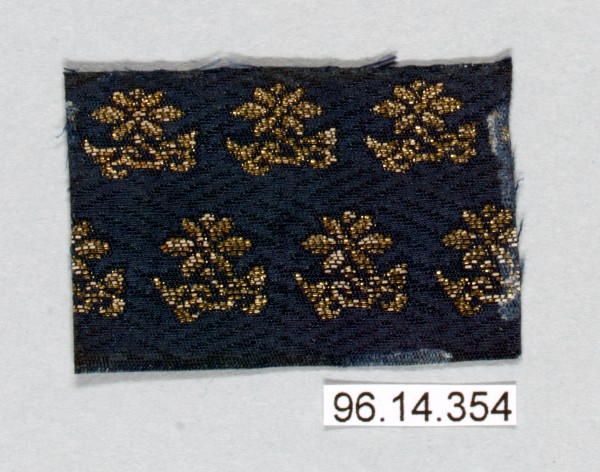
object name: piece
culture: japanese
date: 1701-1900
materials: silk